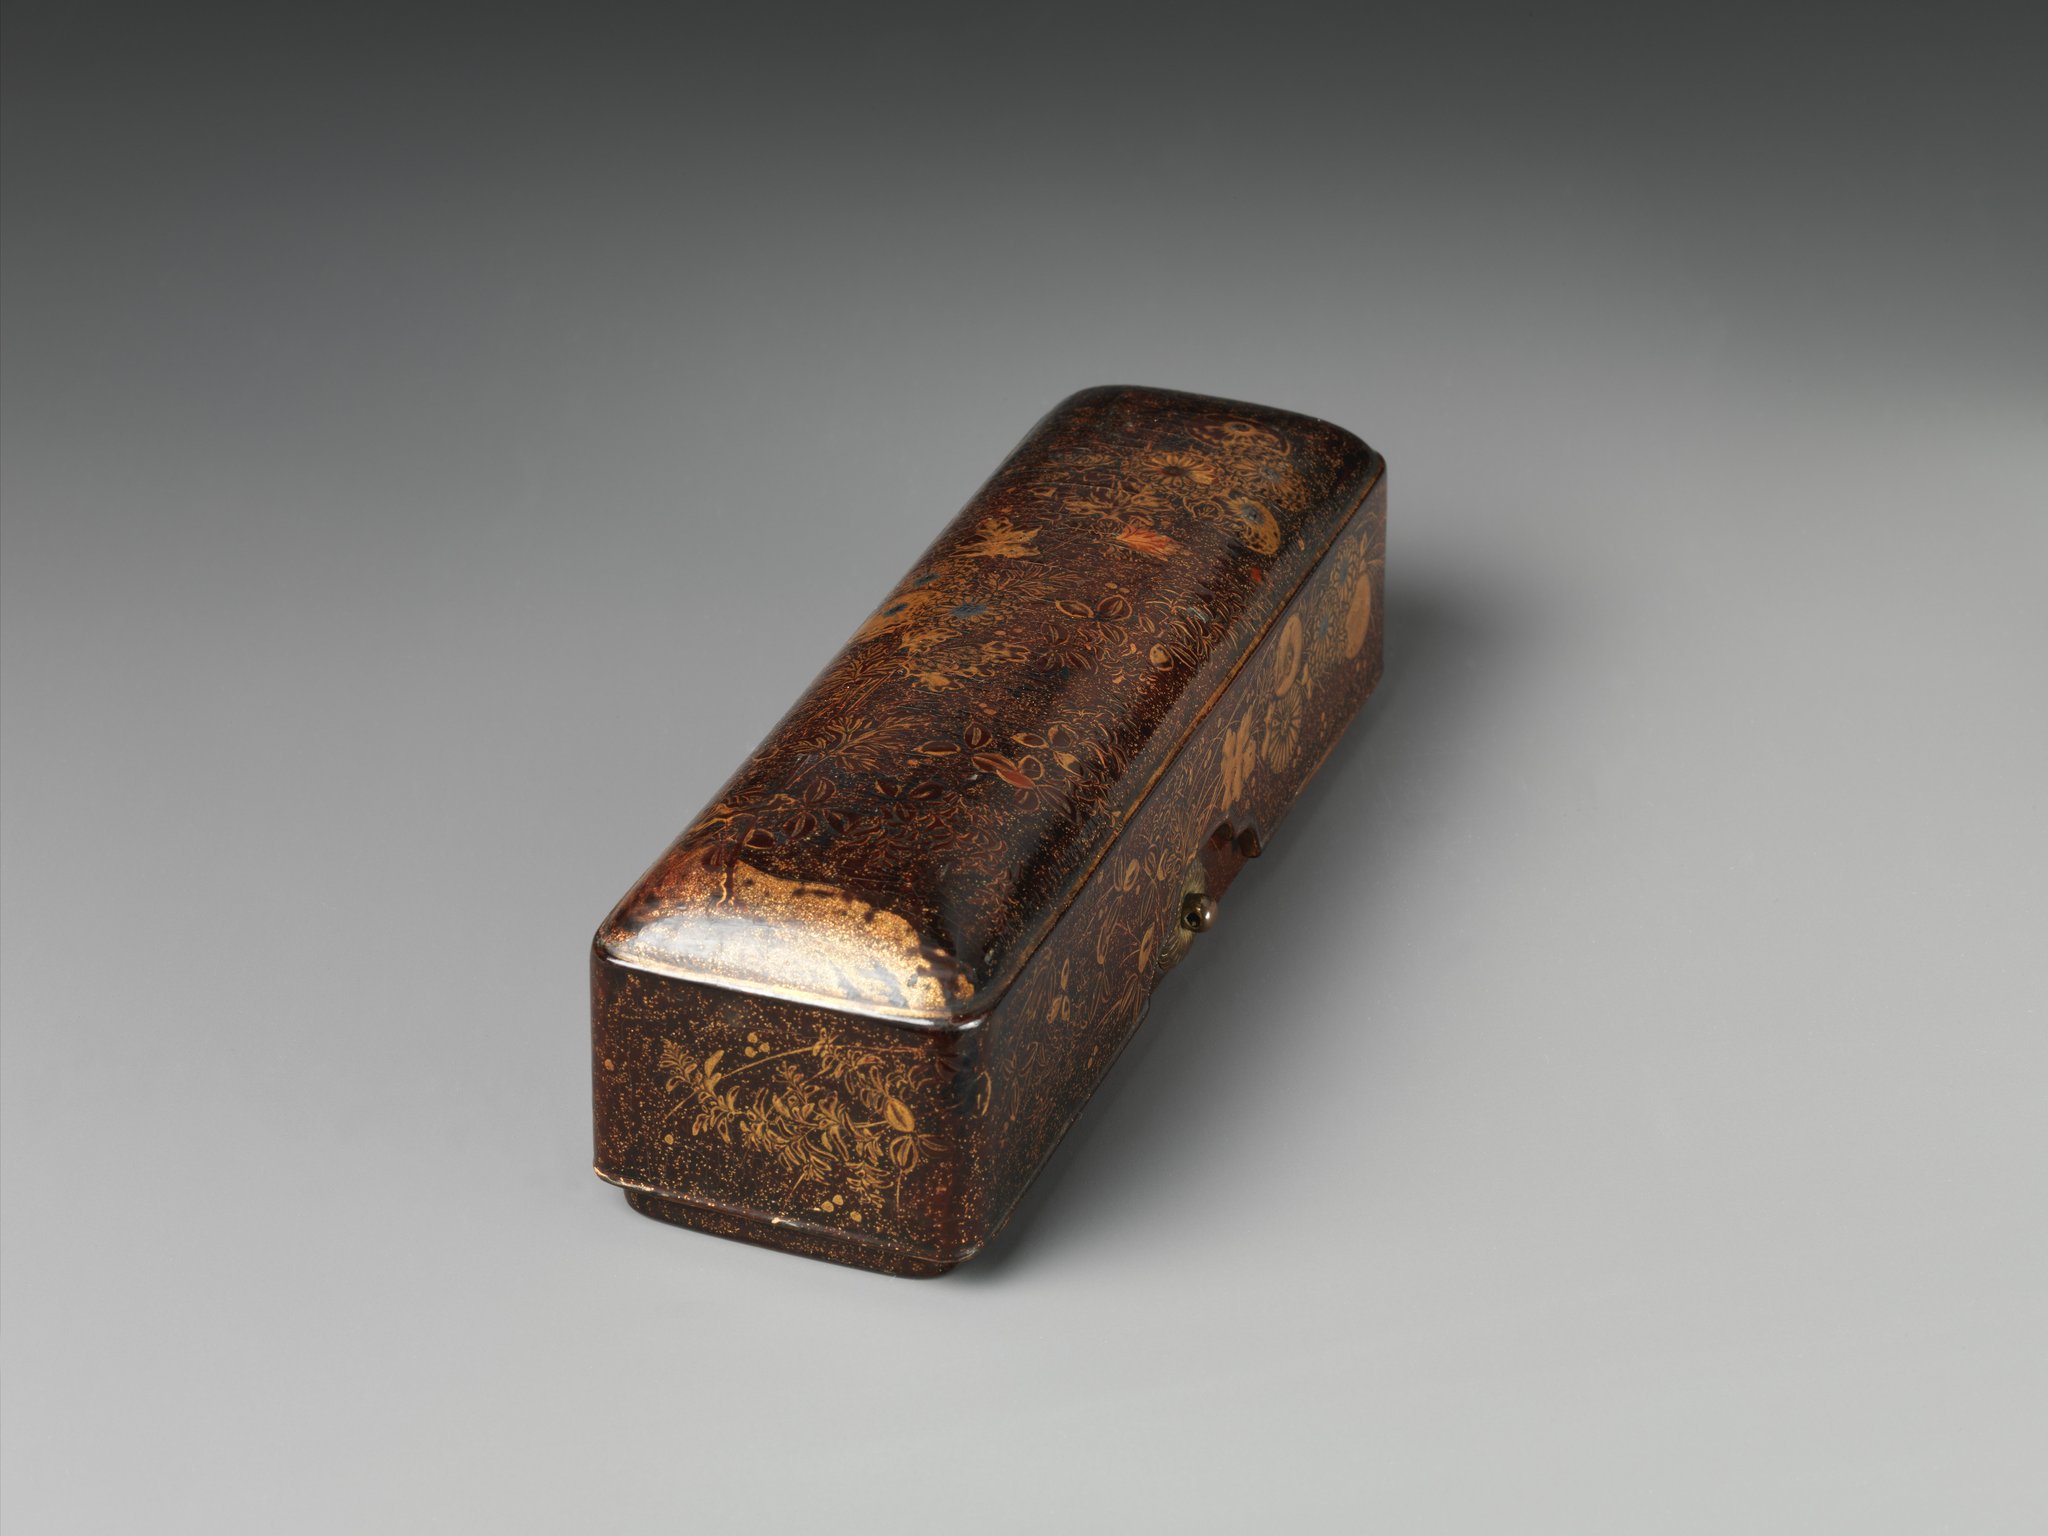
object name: letter box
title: Letter Box with Design of Chrysanthemums and Autumn Grasses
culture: japanese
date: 1401-1500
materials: gold, lacquer, silver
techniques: maki